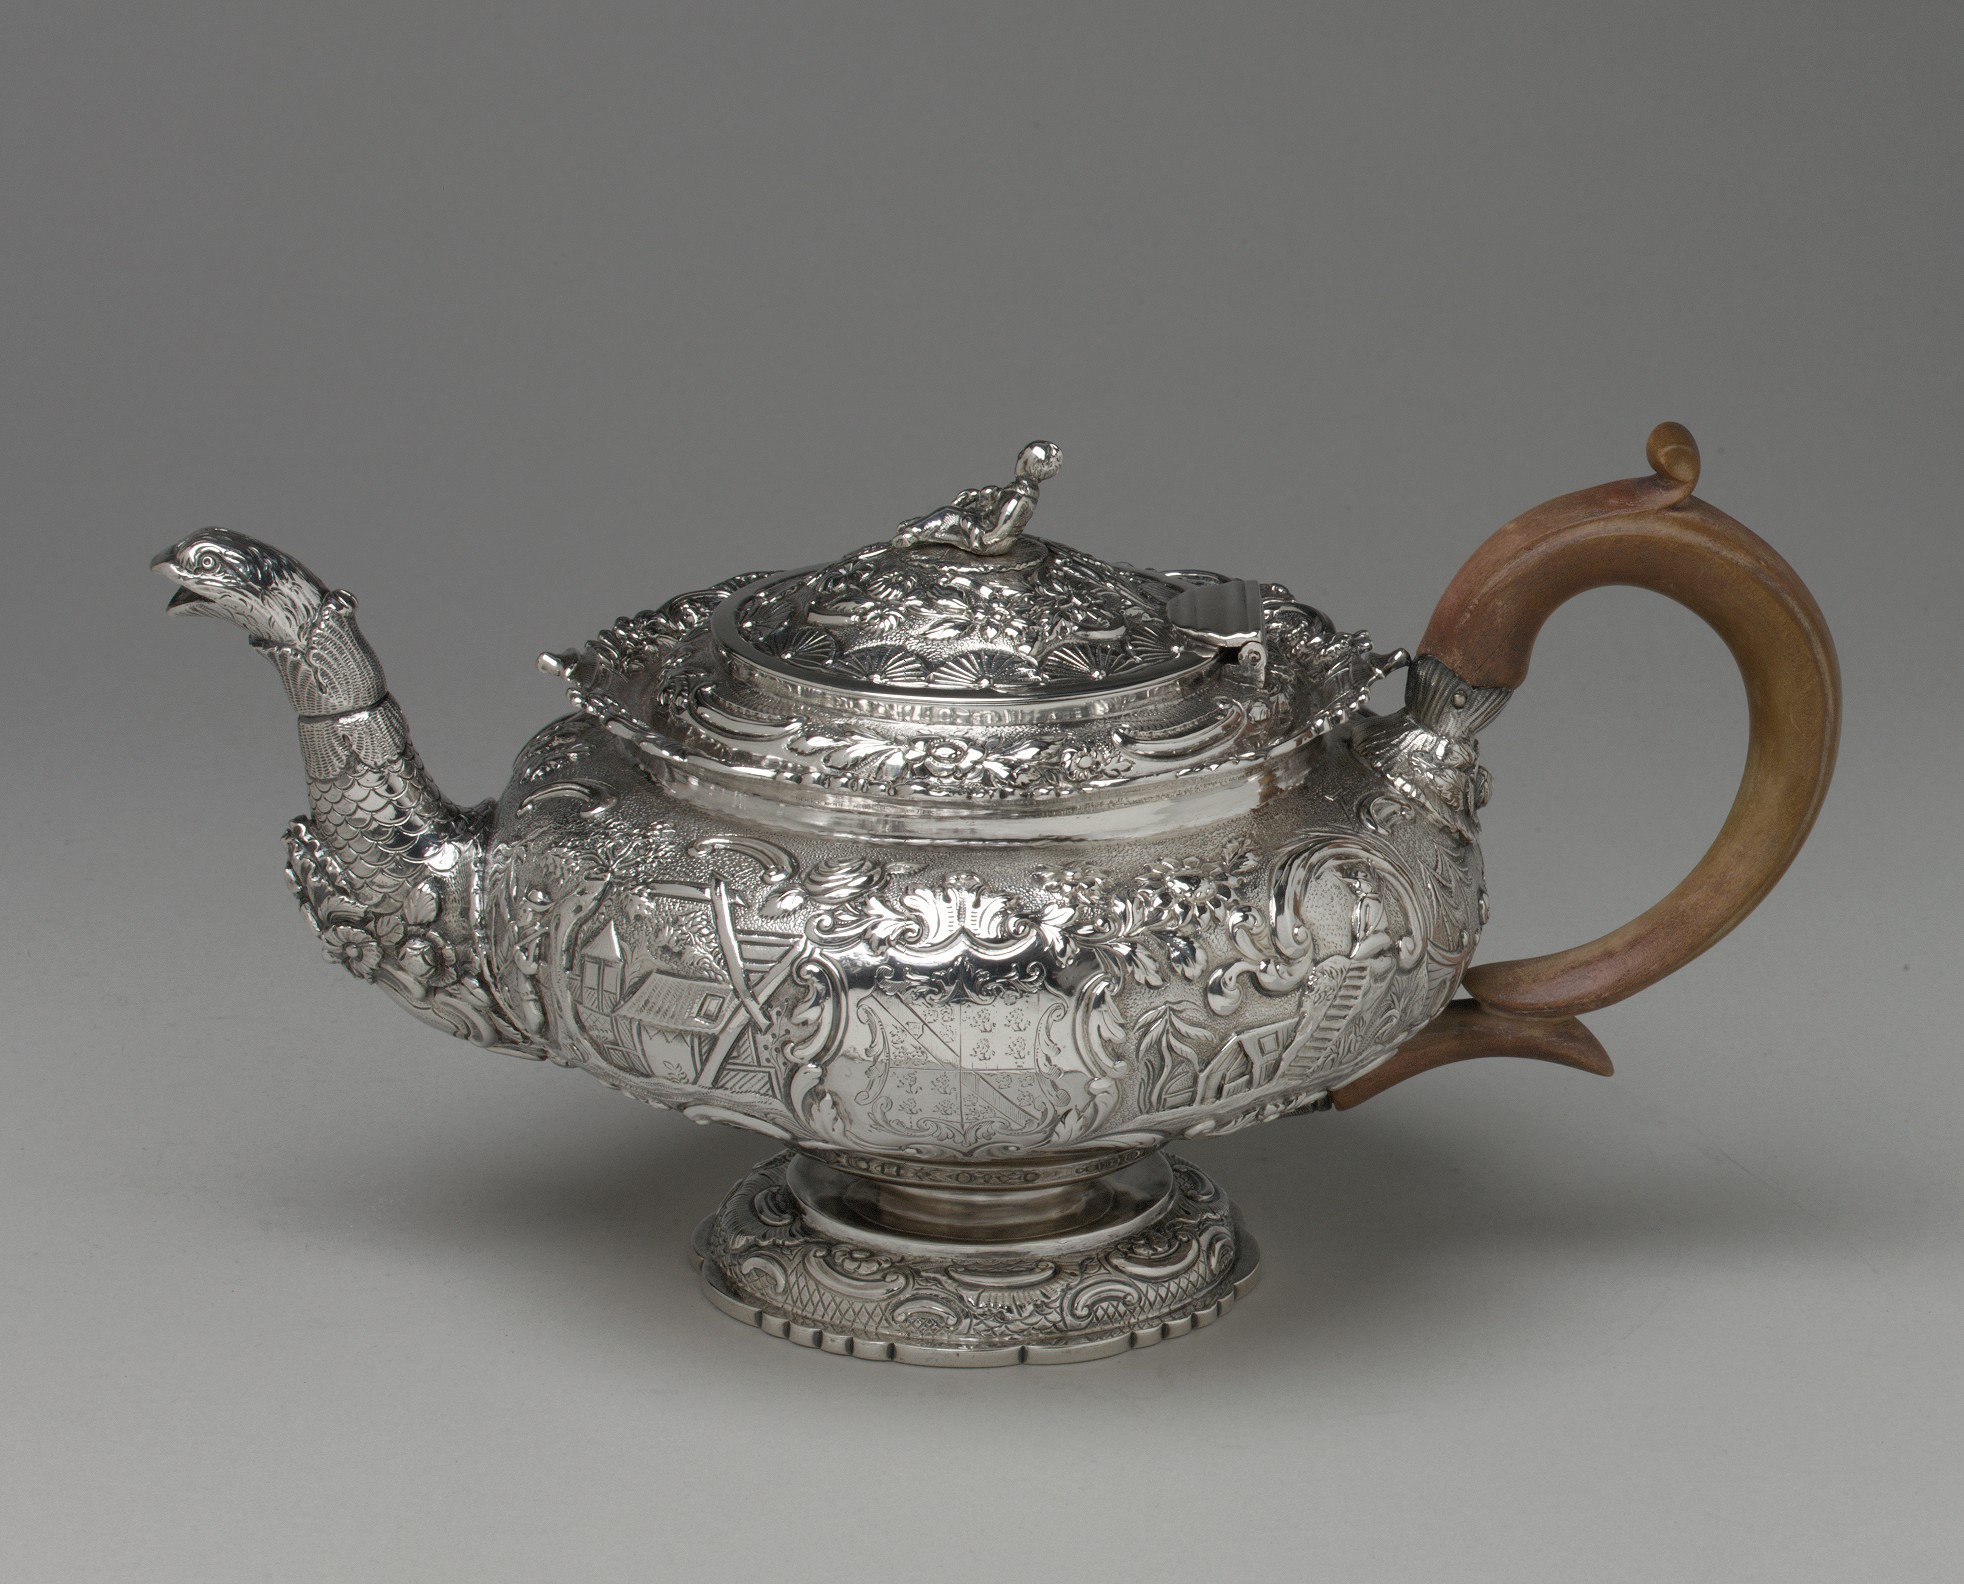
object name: teapot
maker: j.e. terry and co.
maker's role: maker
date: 1820-1821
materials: silver, wood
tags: coat of arms